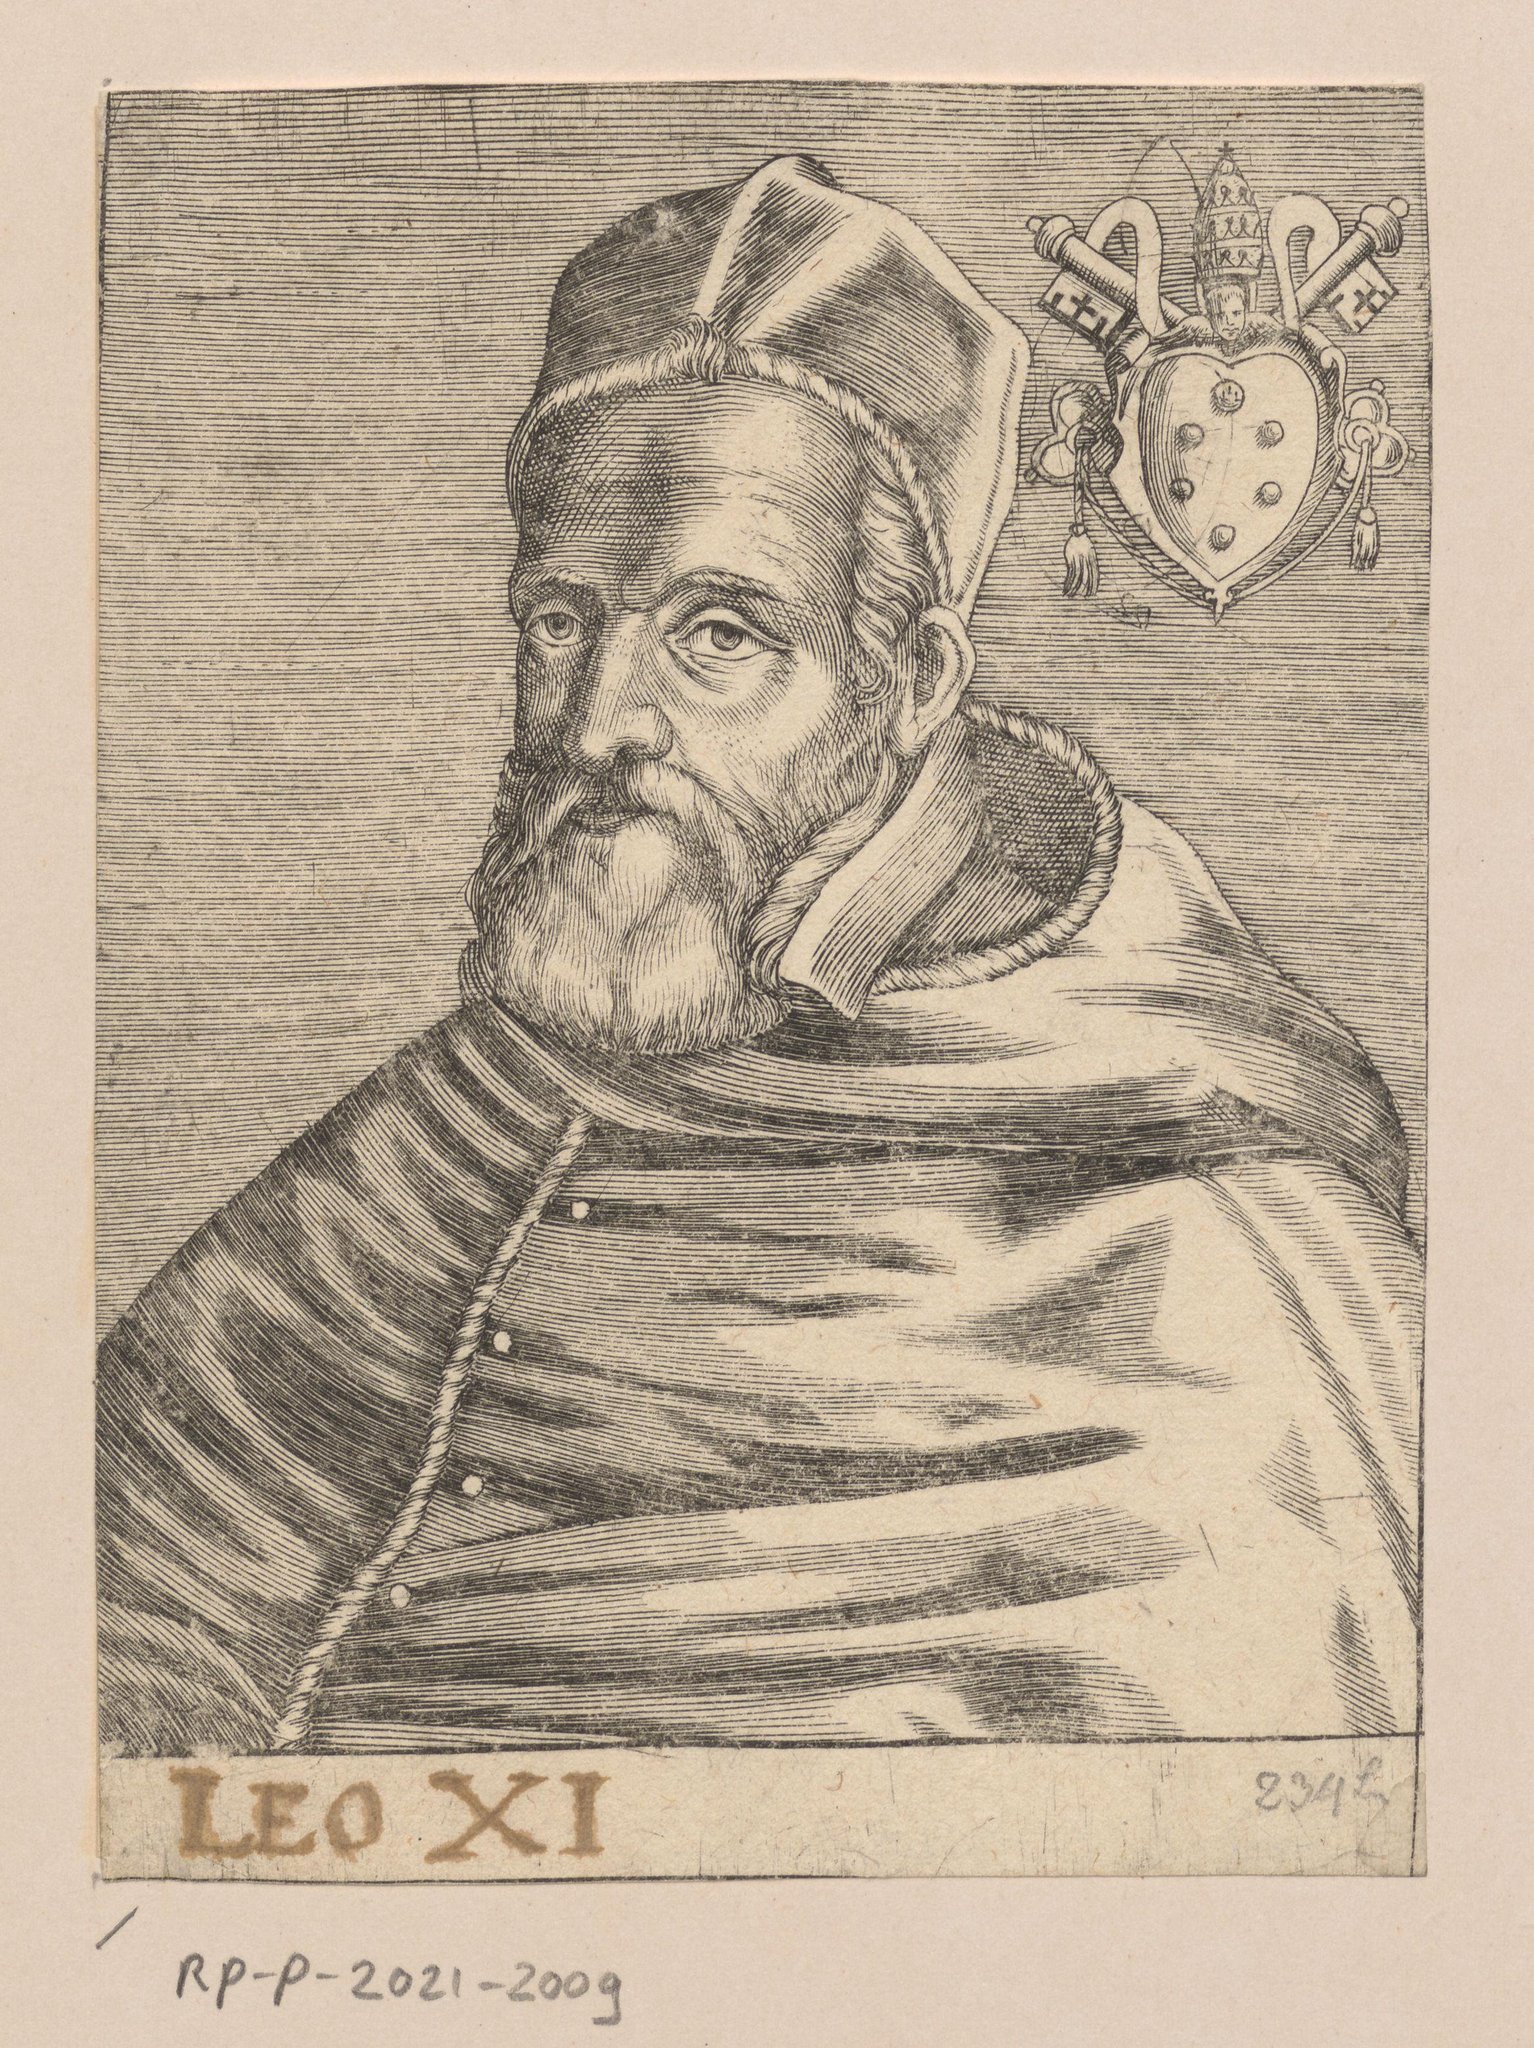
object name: print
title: Portret van Leo XI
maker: Anonymous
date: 1605-1650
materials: paper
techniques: engraving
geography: italy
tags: leo xi, insignia of the pope, e.g. tiara, historical persons, pope, armorial bearing, heraldry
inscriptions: inscription: ‘LEO XI’